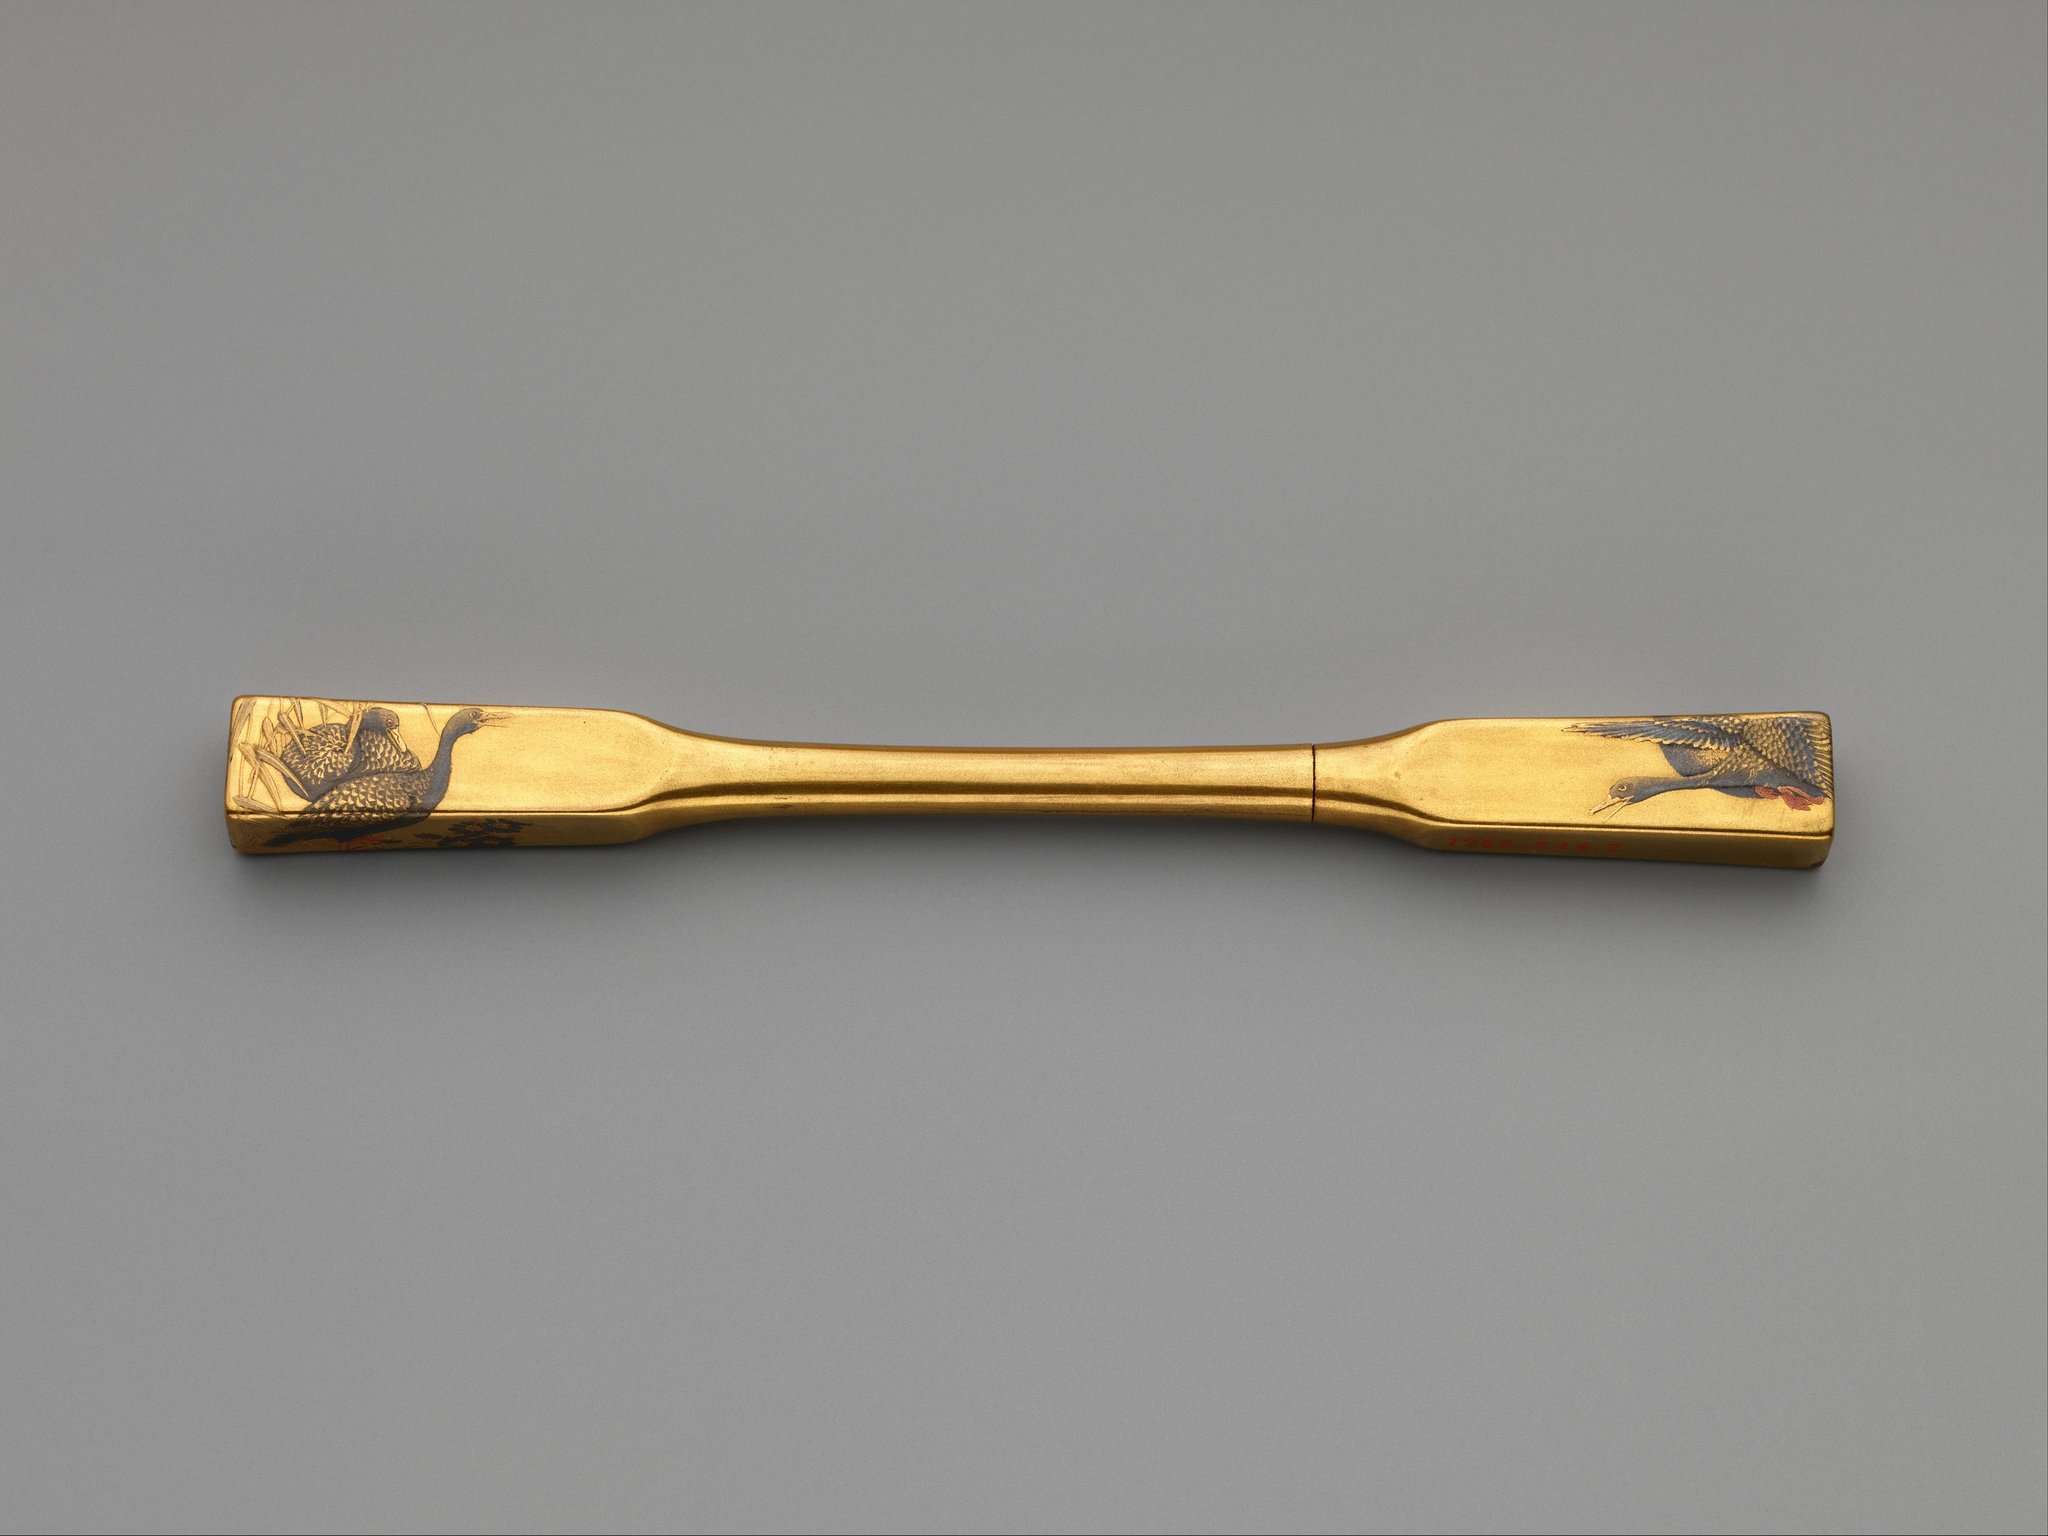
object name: hairpin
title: Lacquer Hairpin with Geese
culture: japanese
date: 1851-1900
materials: gold, gold leaf, silver, wood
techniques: hiramakie, lacquer